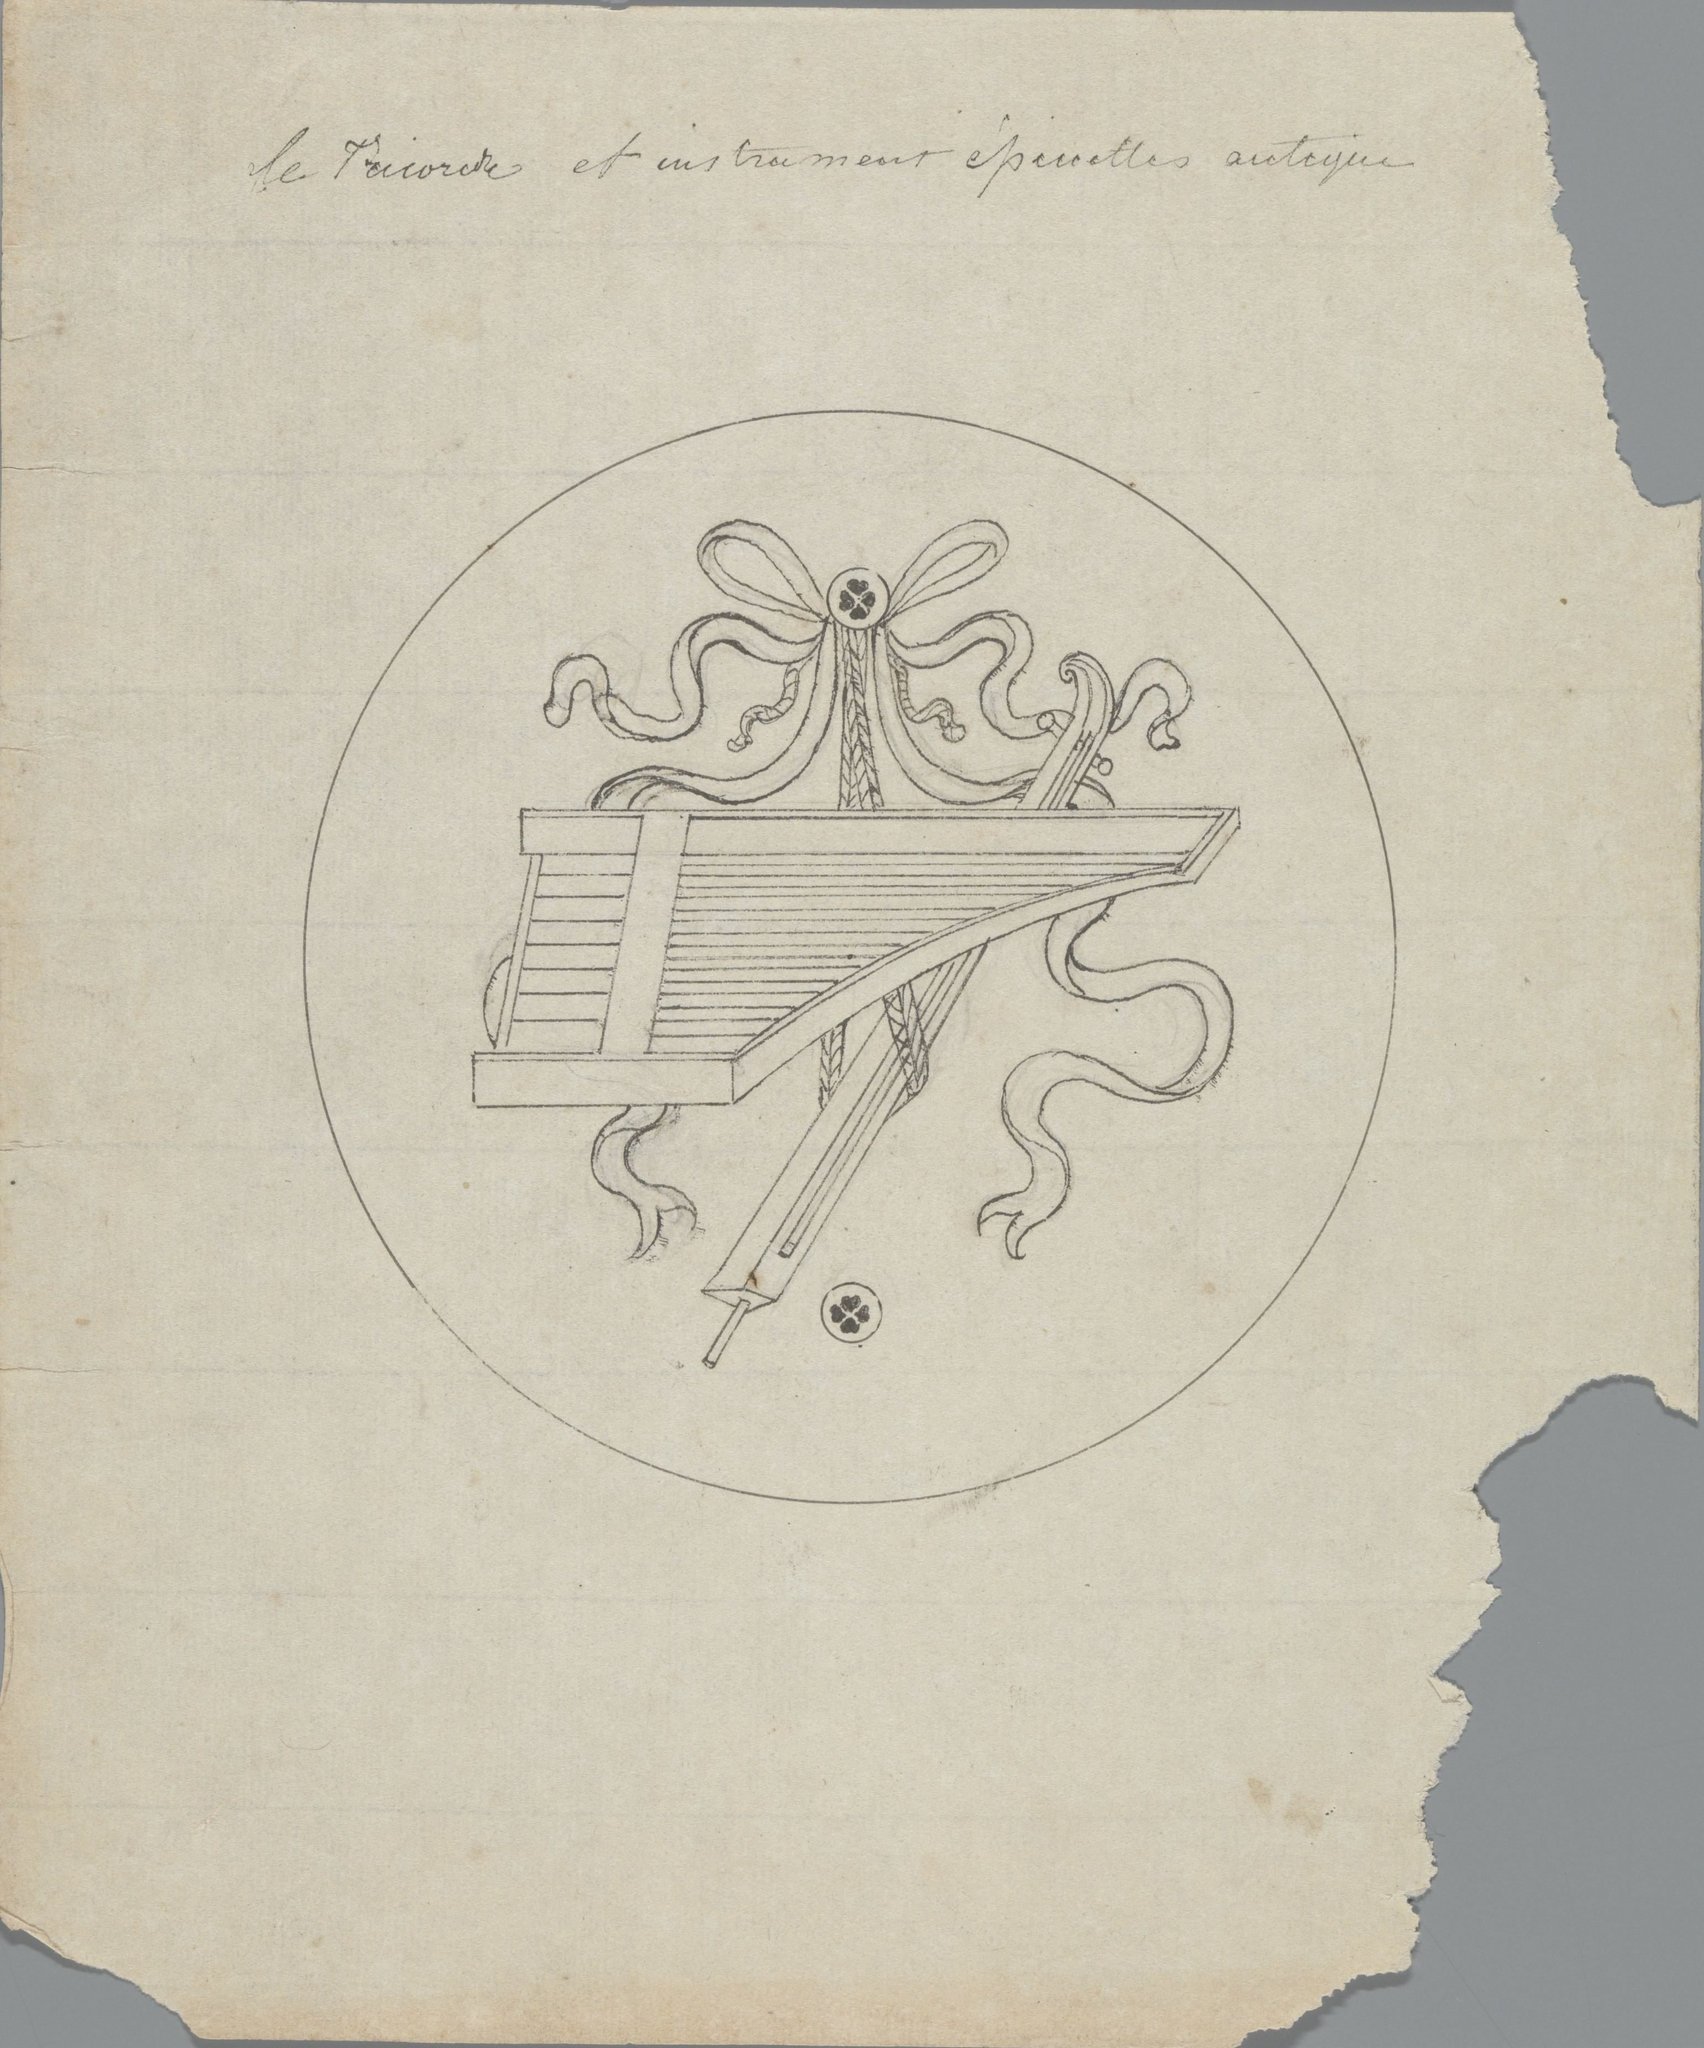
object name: design drawing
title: Le Tricorde et instrument epercettes [?] antique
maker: pierre félix van doren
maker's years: 1797-1856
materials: graphite, ink, paper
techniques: pen in black ink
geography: brussels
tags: trophy, i.e.: decorative arrangement of symbolic or typical objects ~ ornament, string instruments (plucked)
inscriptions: inscription: ‘Le Tricorde et instrument epercettes [?] antique’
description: Een van 103 ontwerpen voor marqueterie van aan linten opgehangen muziekinstrumenten in ronde medaillons, bestemd voor de set stoelen gemaakt door Van Doren voor de grote zaal van het Paleis van de Prins van Oranje in Brussel in 1828.